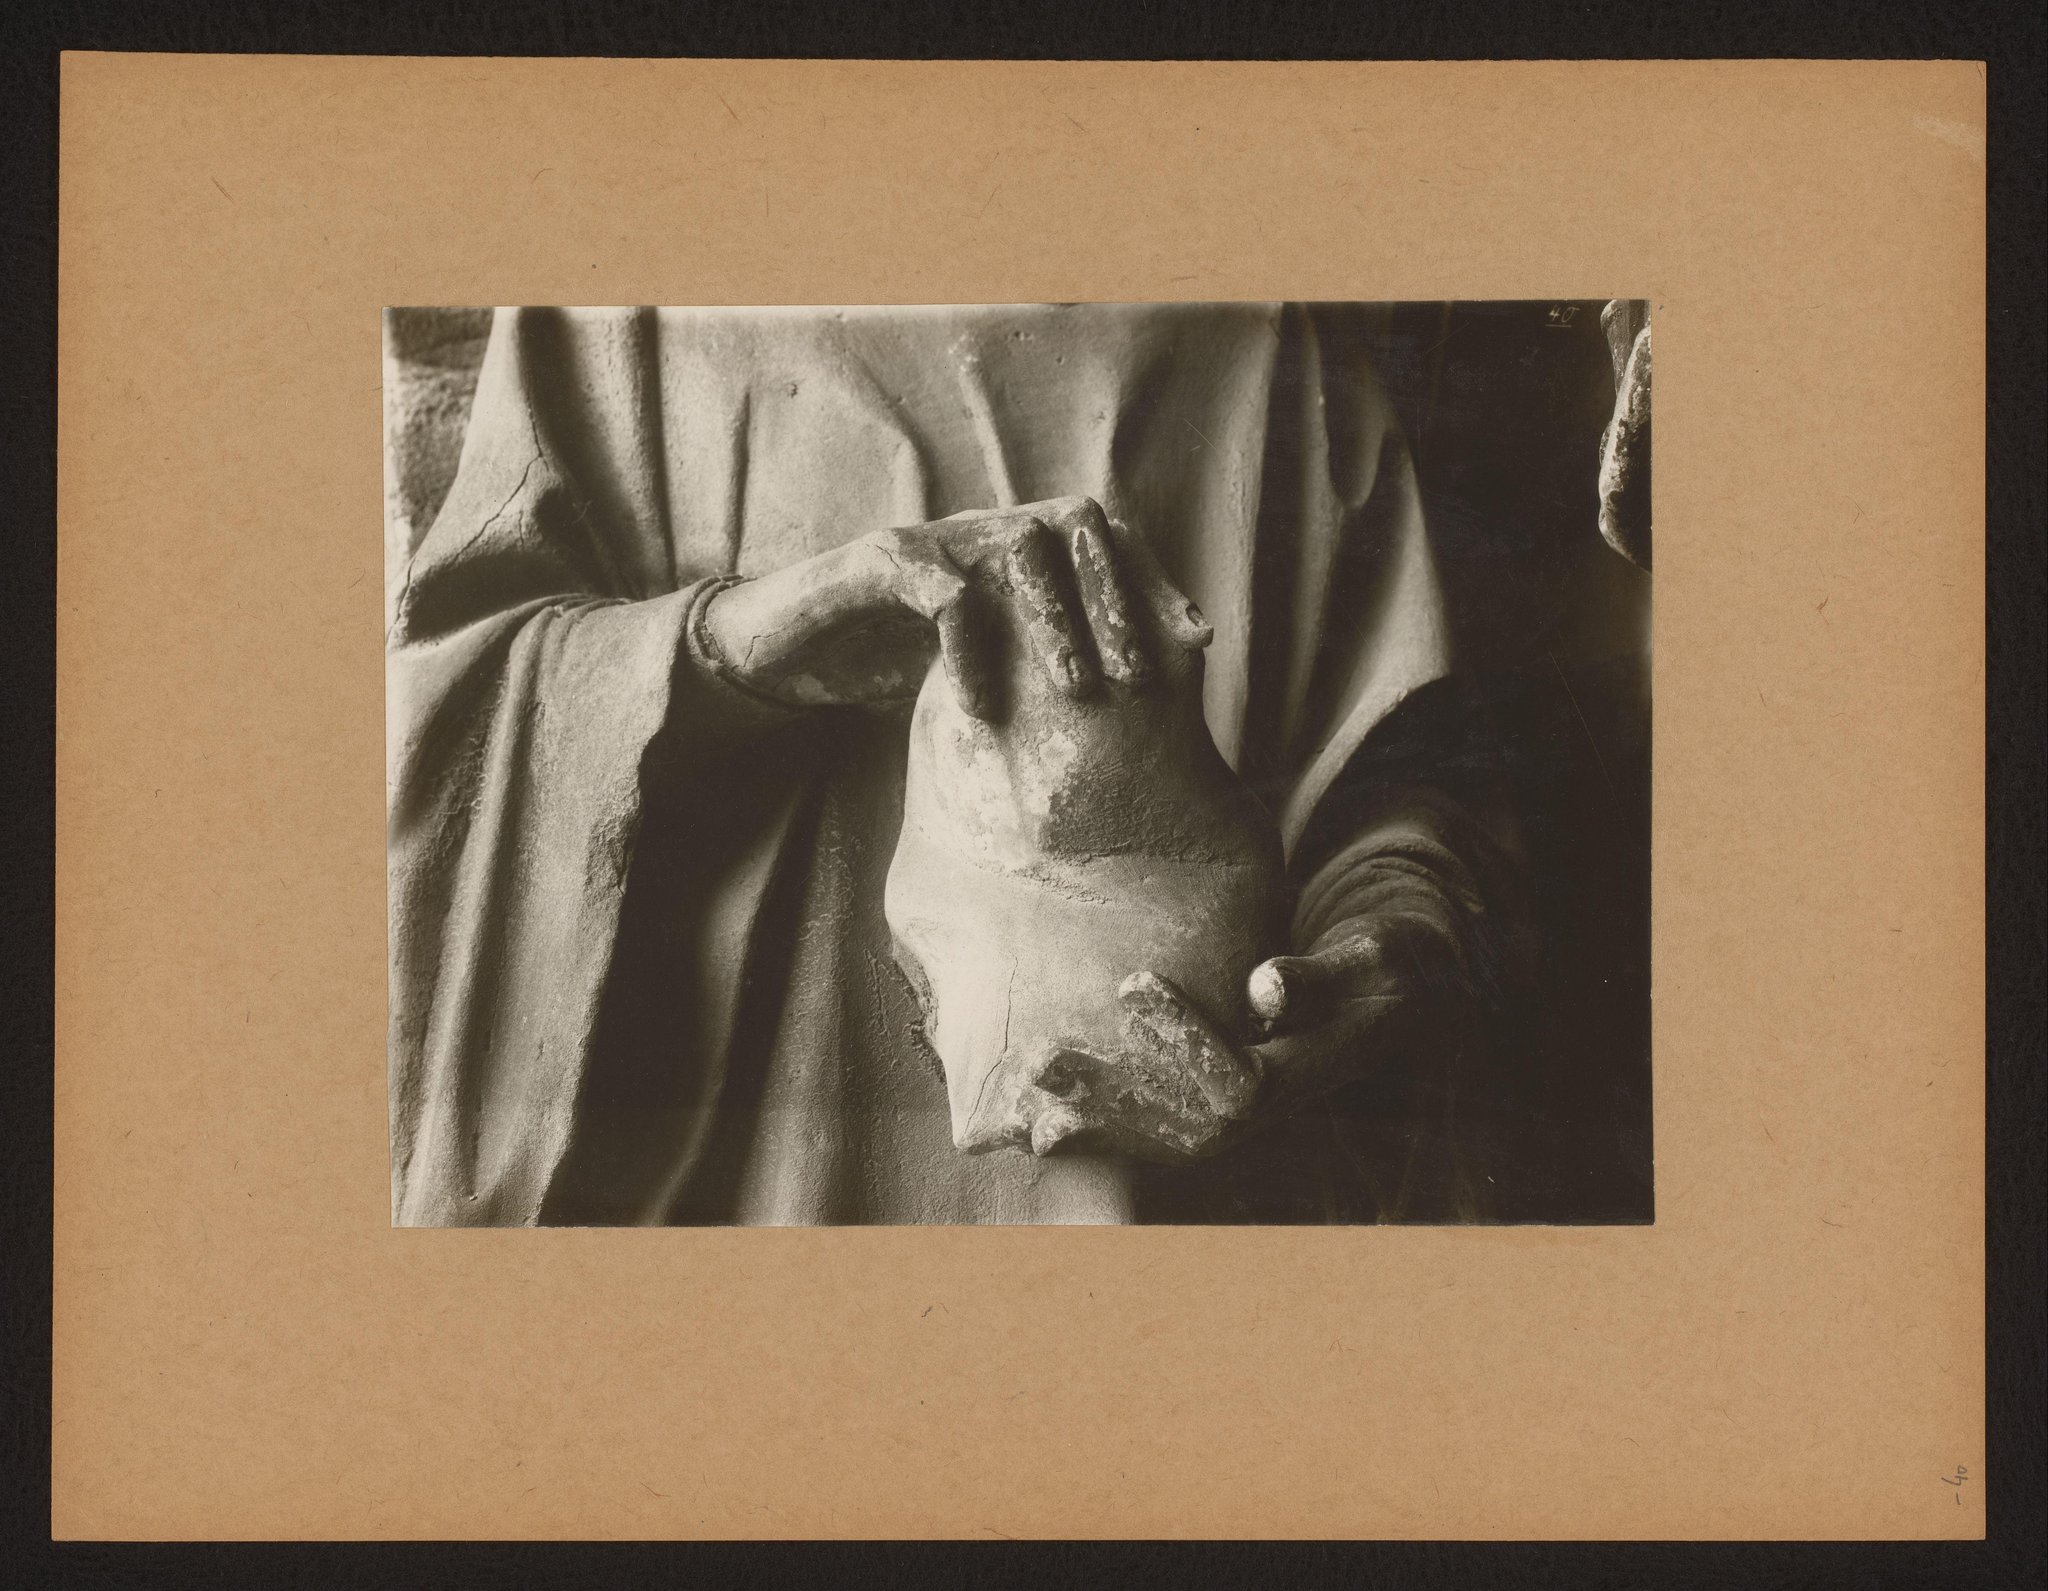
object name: photograph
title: Detail van de Adamspforte in de dom van Bamberg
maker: Anonymous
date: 1900-1920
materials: paper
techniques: gelatin silver print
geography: bamberg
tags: church (exterior)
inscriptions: number: ‘40.’